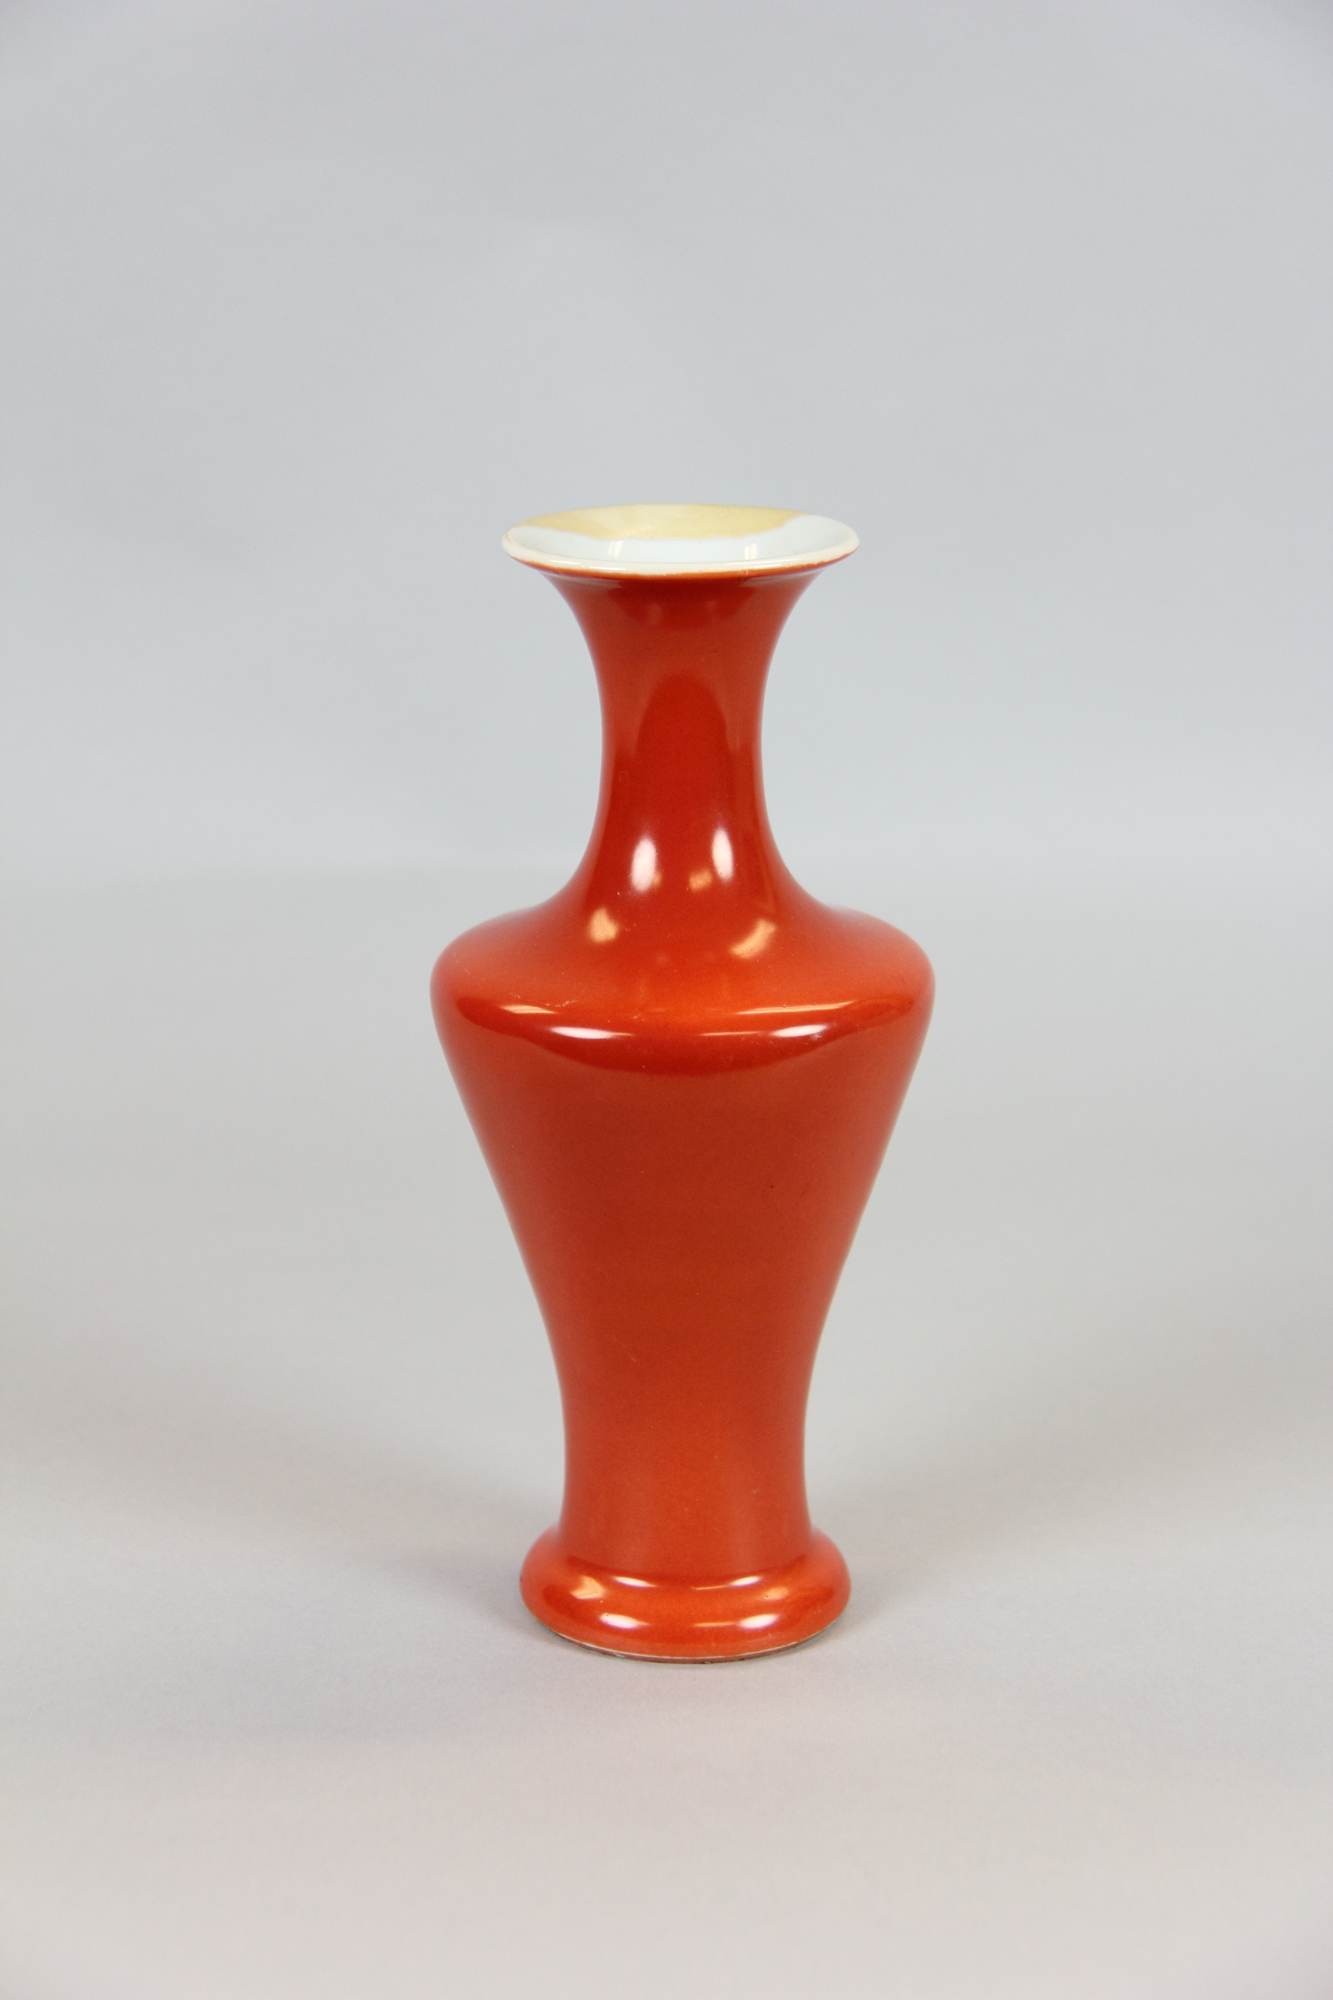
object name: vase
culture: chinese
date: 1701-1800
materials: coral, glaze, porcelain